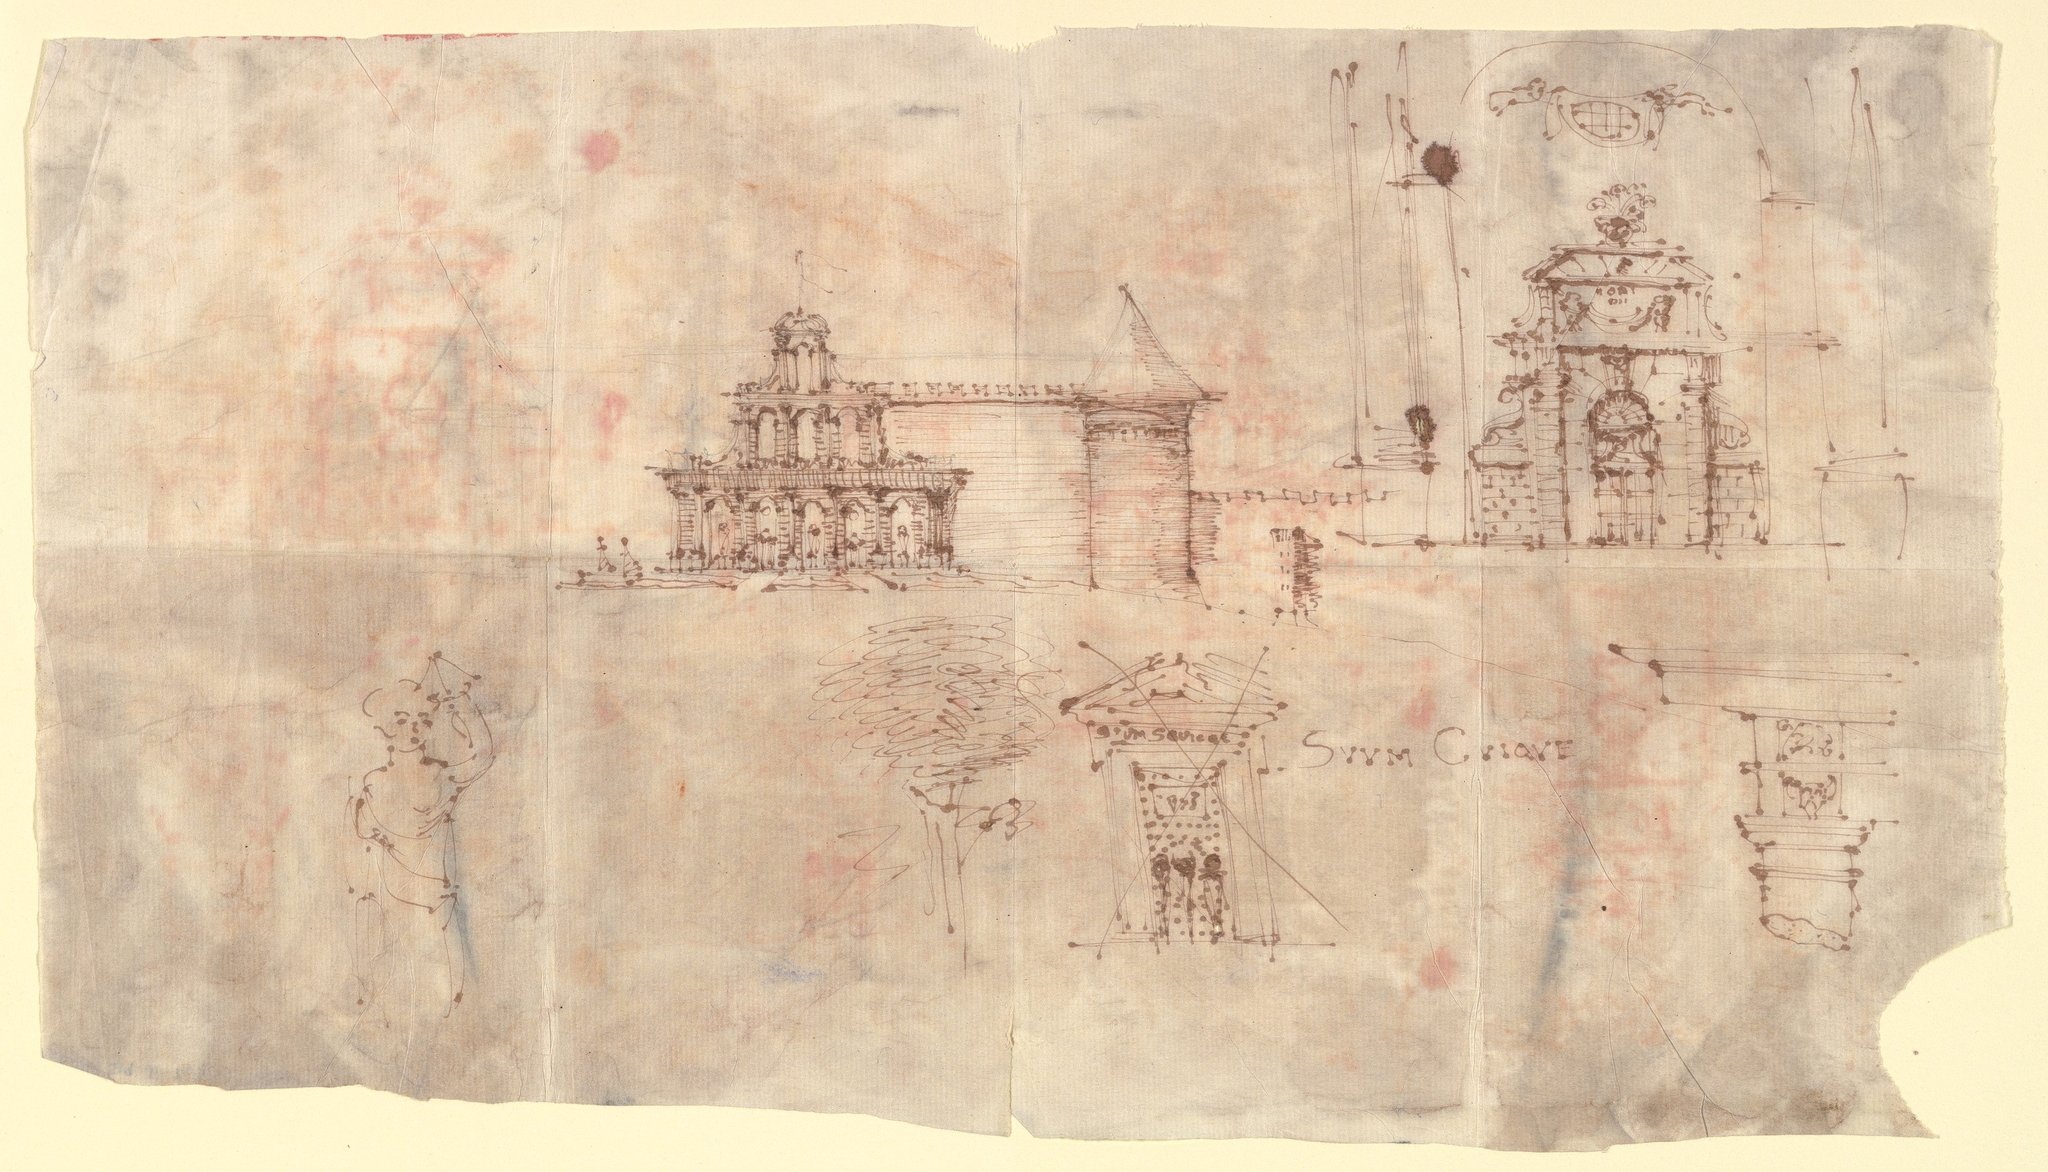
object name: drawing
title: Studies of Architectural Motifs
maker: anonymous, french, 18th century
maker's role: artist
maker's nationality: french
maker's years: 1700-1800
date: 1701-1800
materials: chalk, ink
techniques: pen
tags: architecture